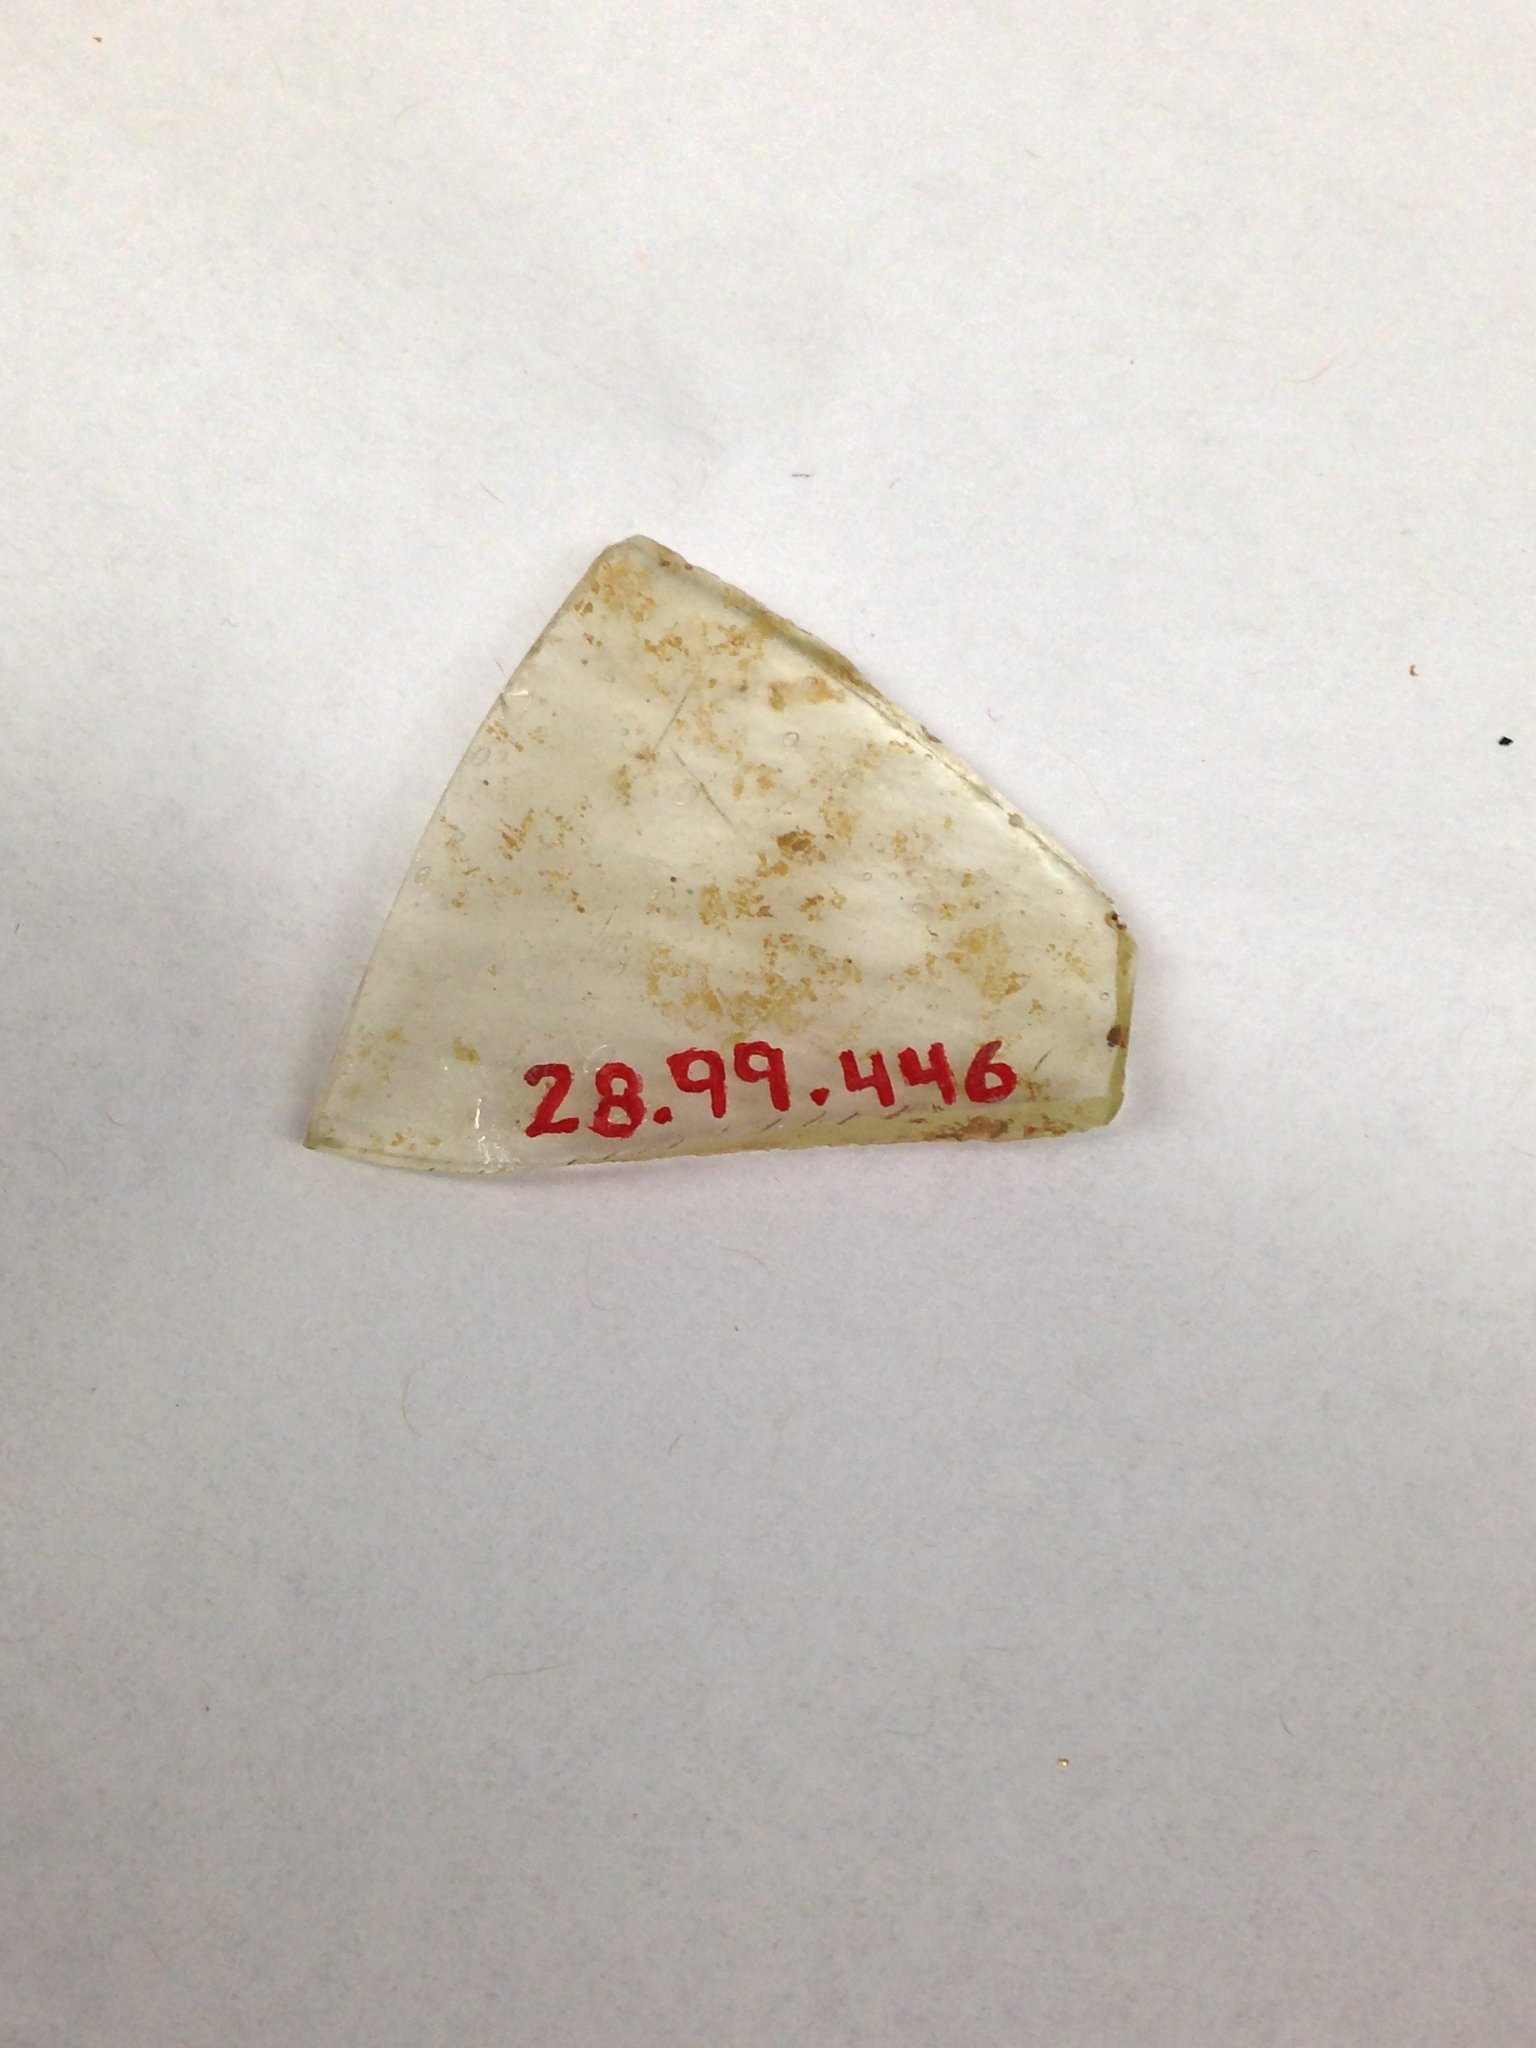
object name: fragment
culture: european or middle eastern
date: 1150-1250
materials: ceramic, glass